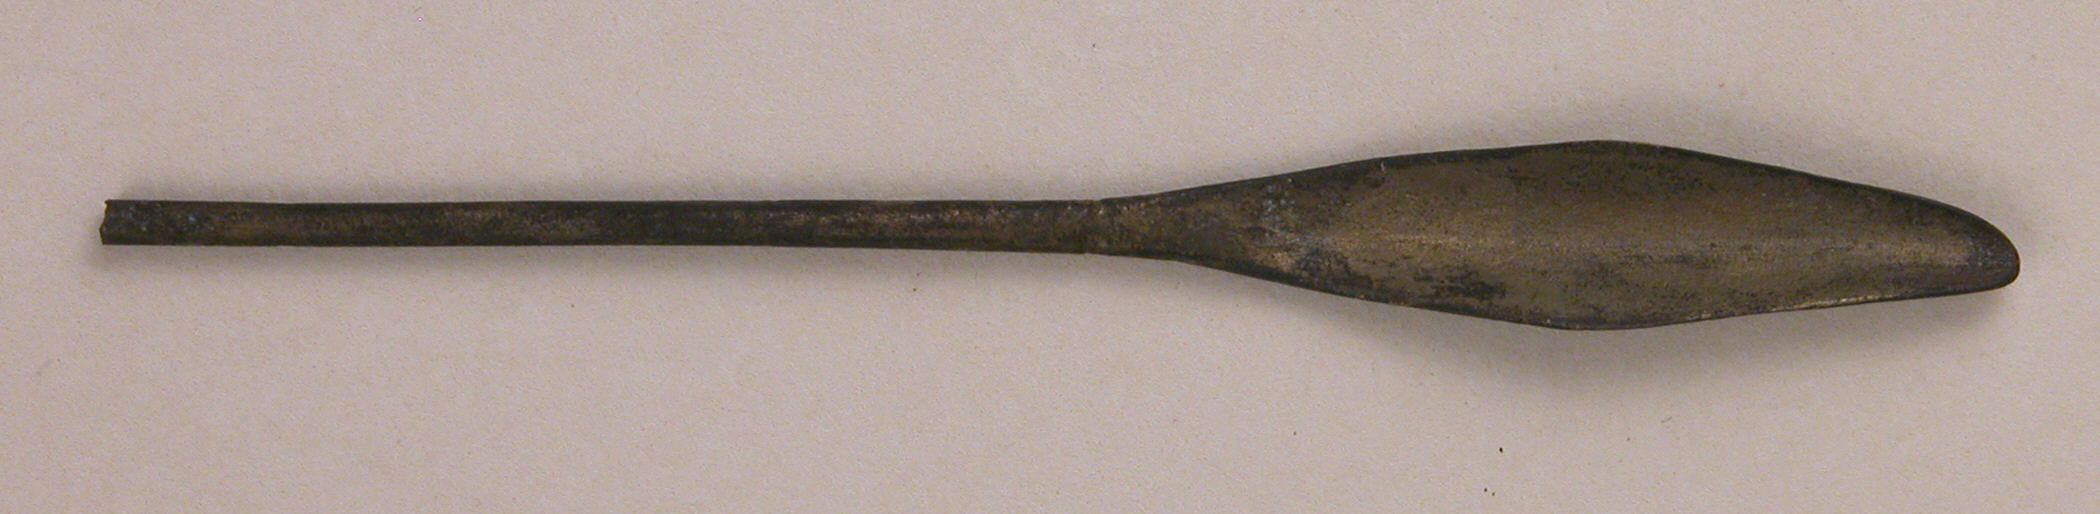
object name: spoon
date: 401-800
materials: bronze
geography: palestine